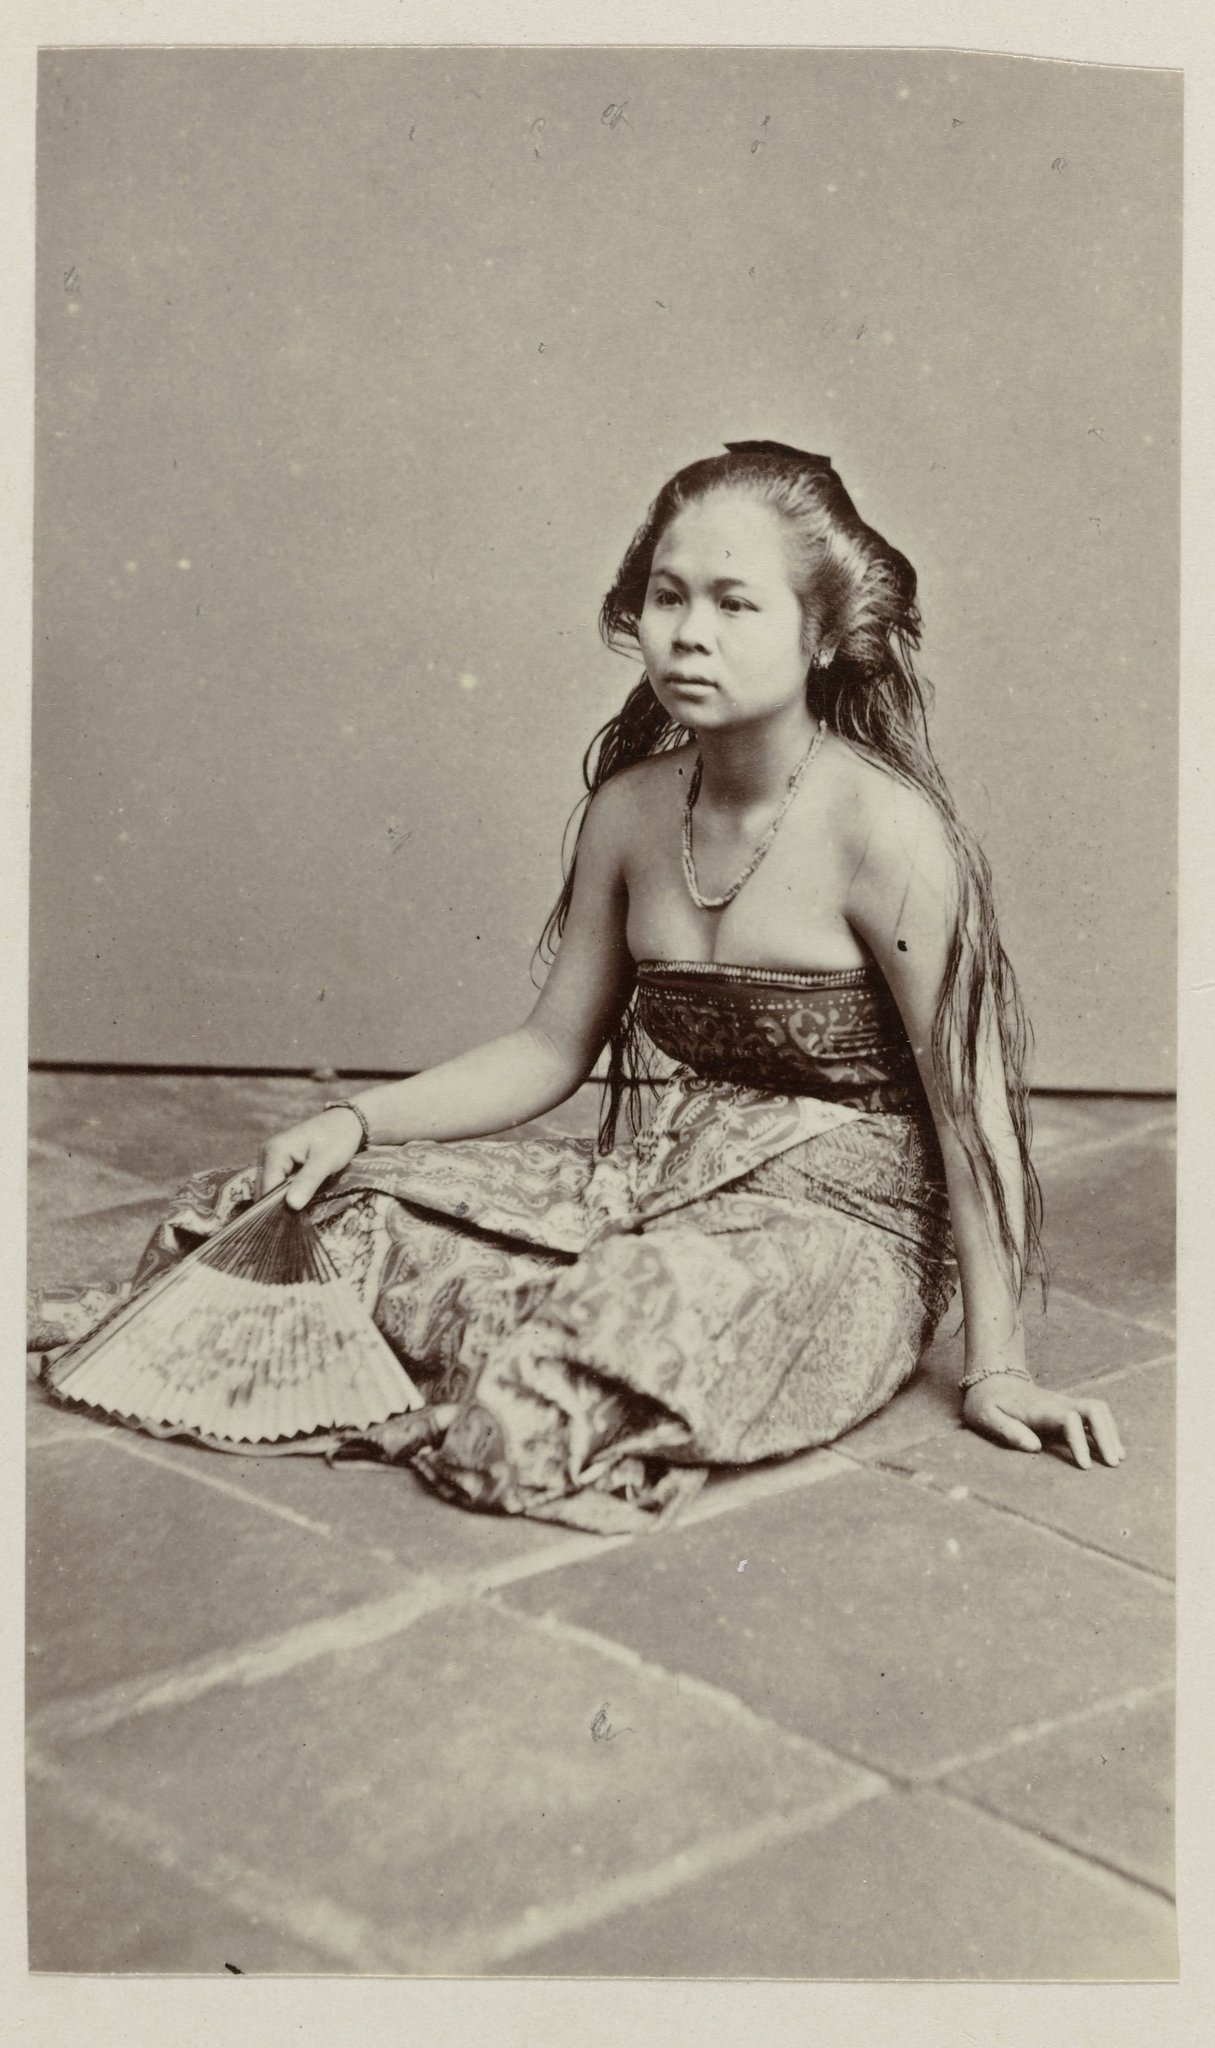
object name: photograph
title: Zittend meisje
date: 1860-1880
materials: photographic support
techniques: albumen print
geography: batavia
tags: historical persons not known by name - bb - woman, java, batavia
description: Studioportret van een zittend Indisch meisje met een waaier. Ingeplakte foto in het fotoalbum getiteld: Gezichten van Java.